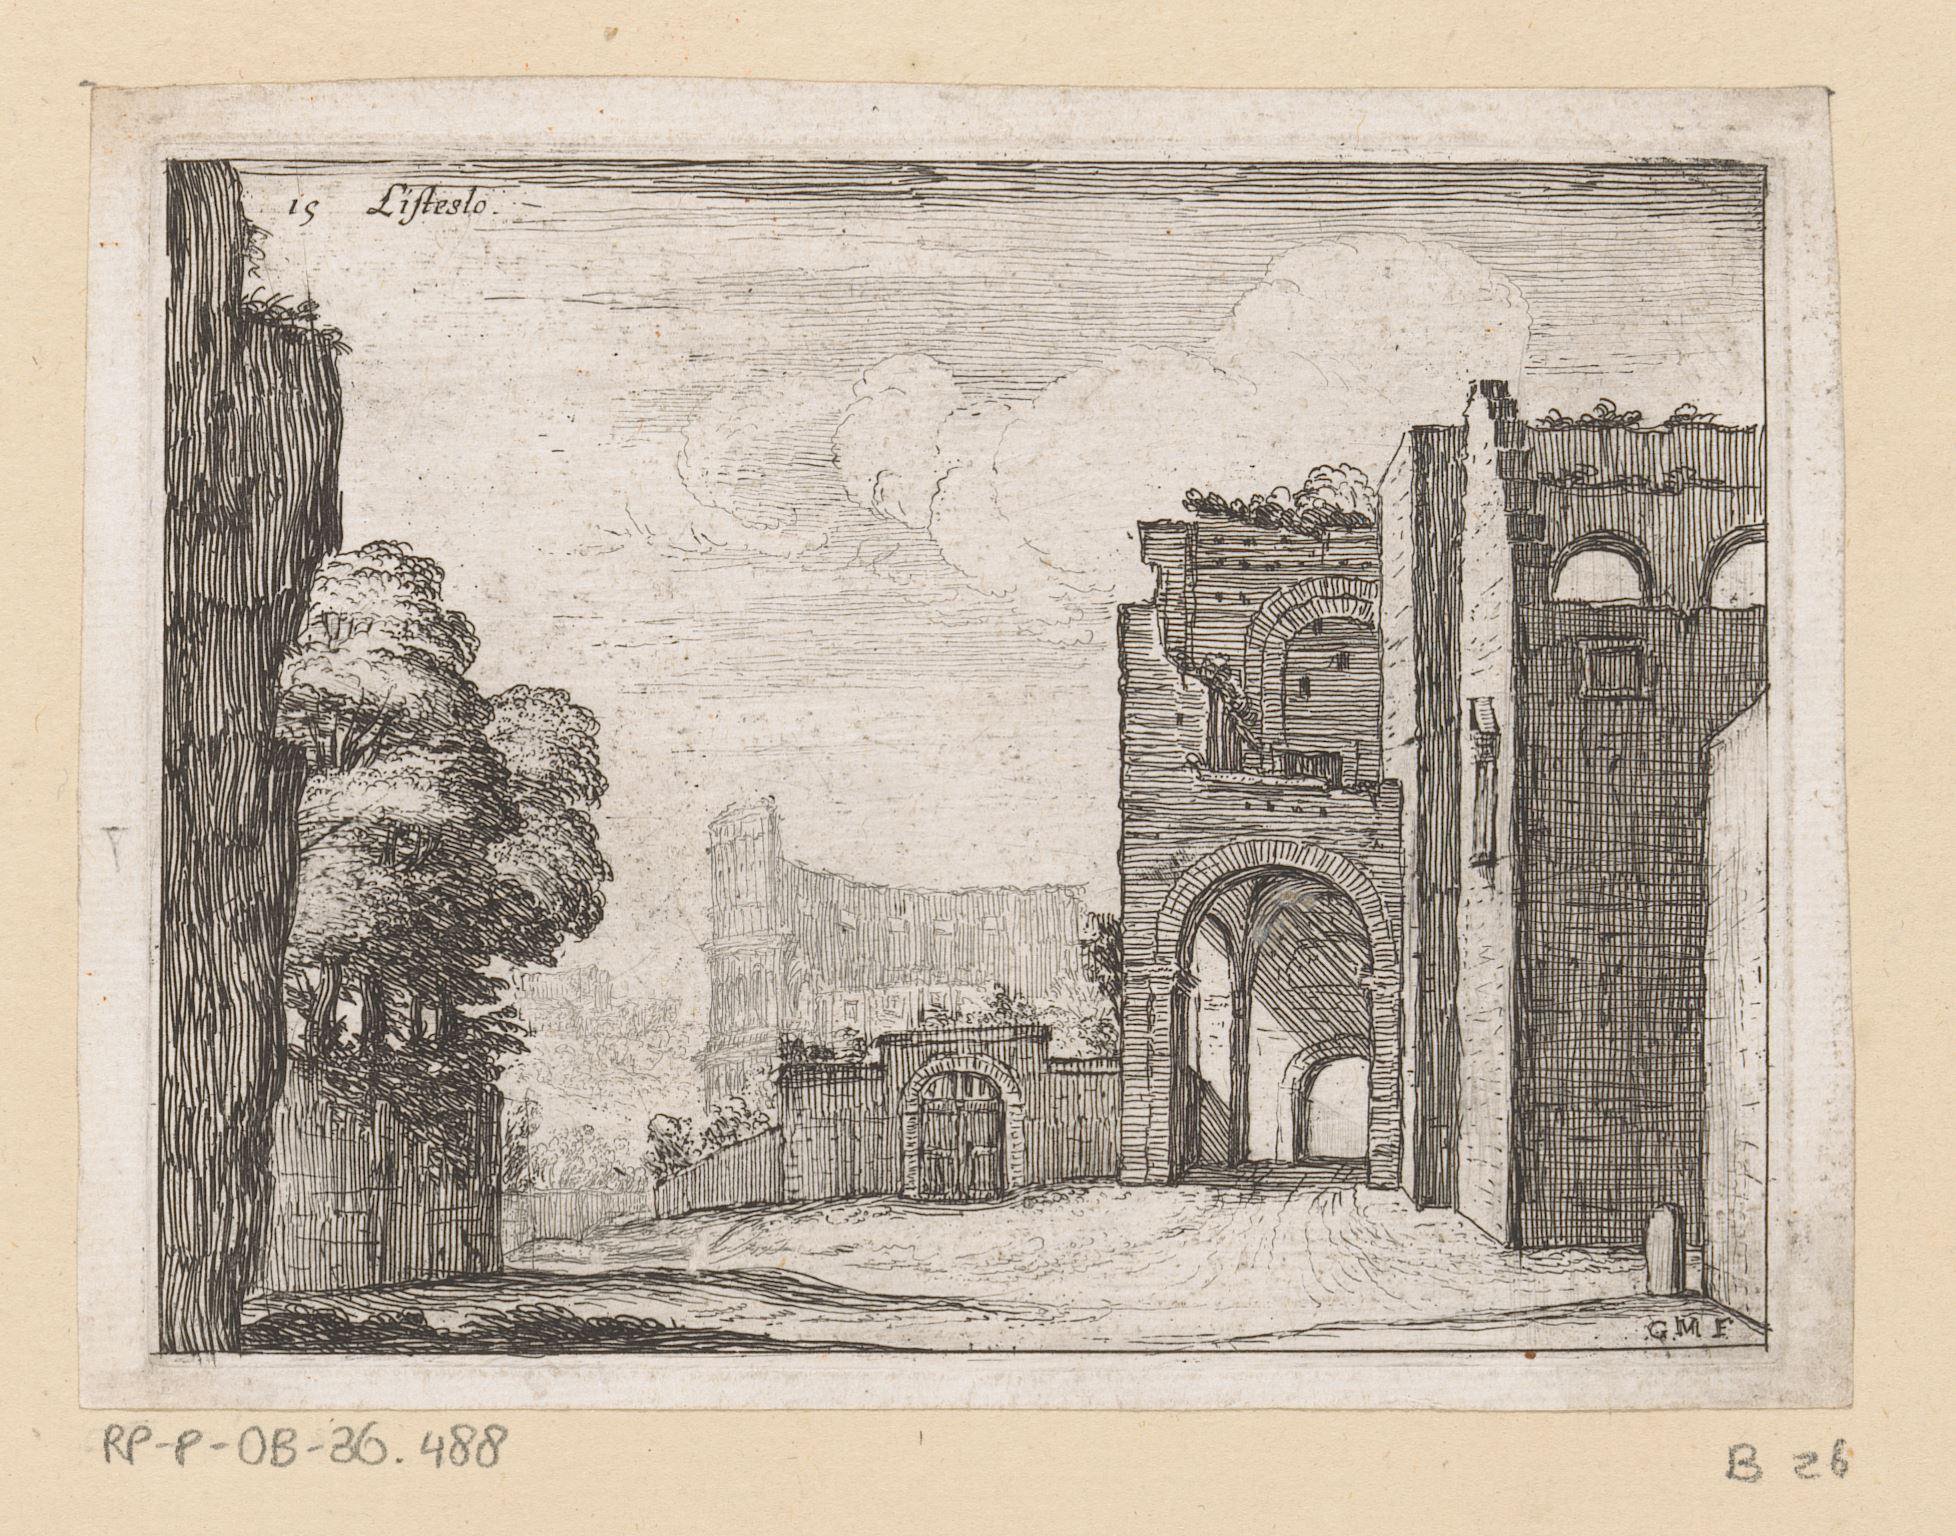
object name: print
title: Listesso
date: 1629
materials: paper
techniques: etching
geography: italy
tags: landscape with ruins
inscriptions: collector's mark: Lugt 2228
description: Deze prent maakt deel uit van een reeks van 52 prenten.